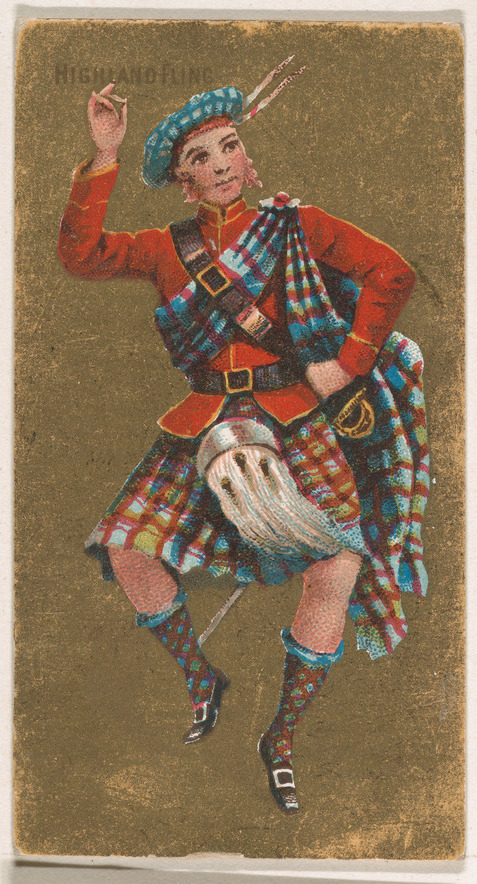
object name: print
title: Highland Fling, from National Dances (N225, Type 2) issued by Kinney Bros.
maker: kinney brothers tobacco company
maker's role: publisher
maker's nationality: american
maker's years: 1869-2011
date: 1889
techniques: color lithograph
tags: women,dancing,dancers